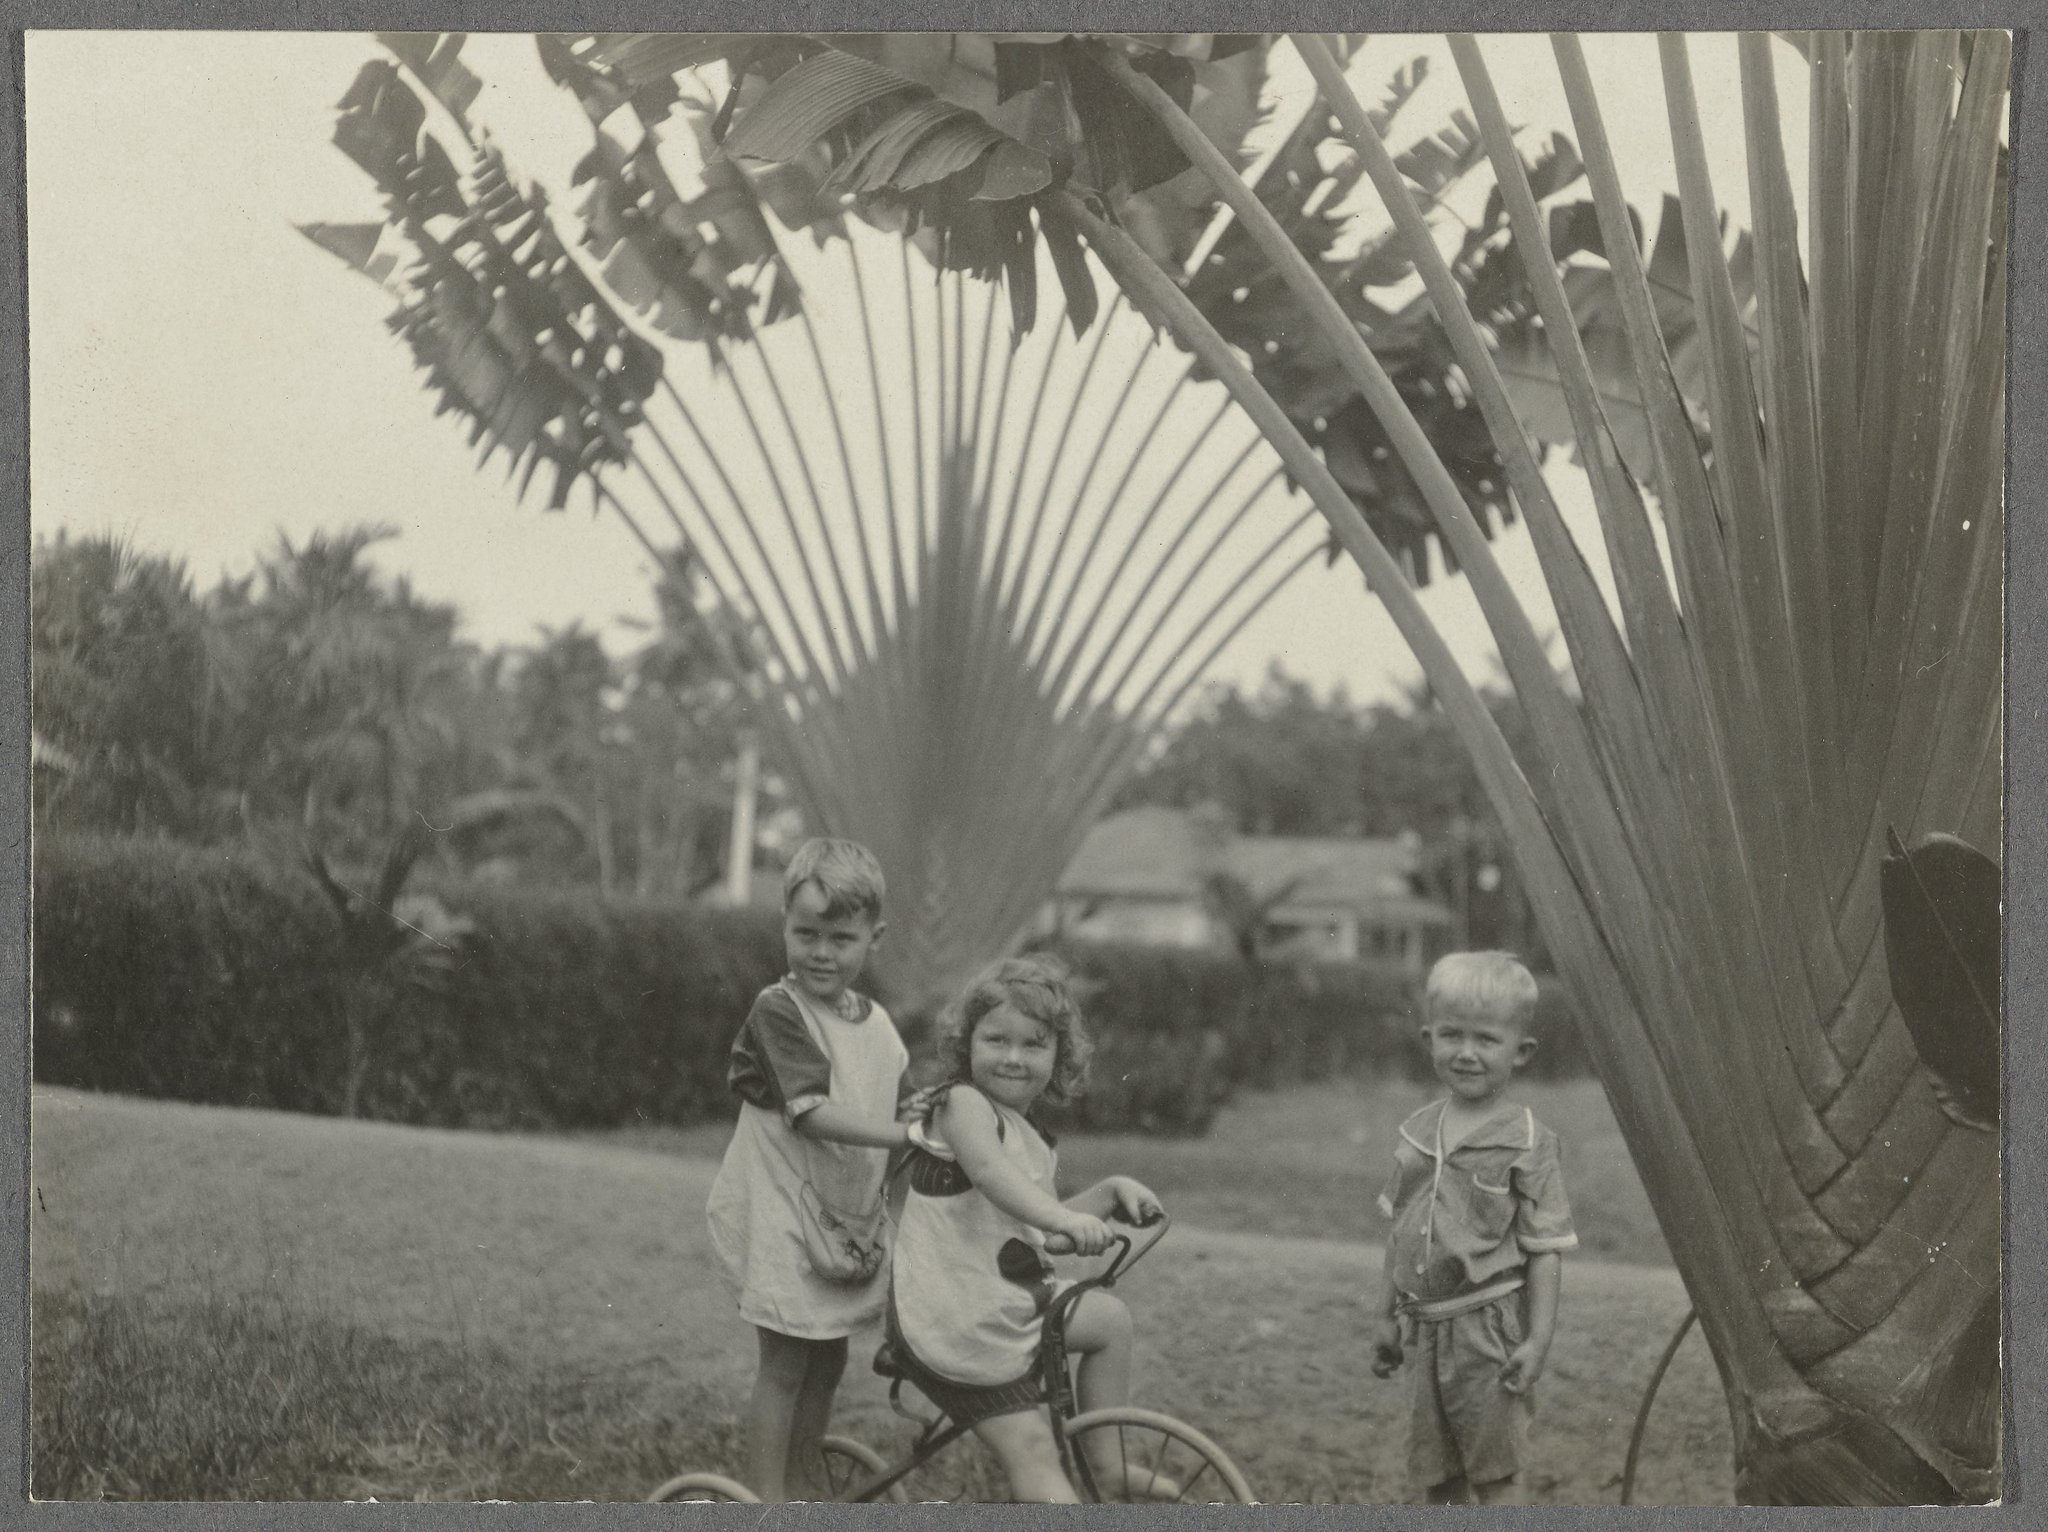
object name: photograph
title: Klaas en Tiny Kleiterp en een onbekende kleuter (rechts) spelend met een driewieler in een tuin in Singkawang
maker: klaas kleiterp (i)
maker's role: arts, officier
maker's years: 1892-1943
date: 1910-1924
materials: paper, photographic support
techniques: gelatin silver print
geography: singkawang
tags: tricycle, garden, child, (playing with) toys, dutch east indies, the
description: Onderdeel van Fotoalbum van de familie Kleiterp-Vermeulen met opnames van de kinderen Klaas en Tiny in Nederlands-Indië.